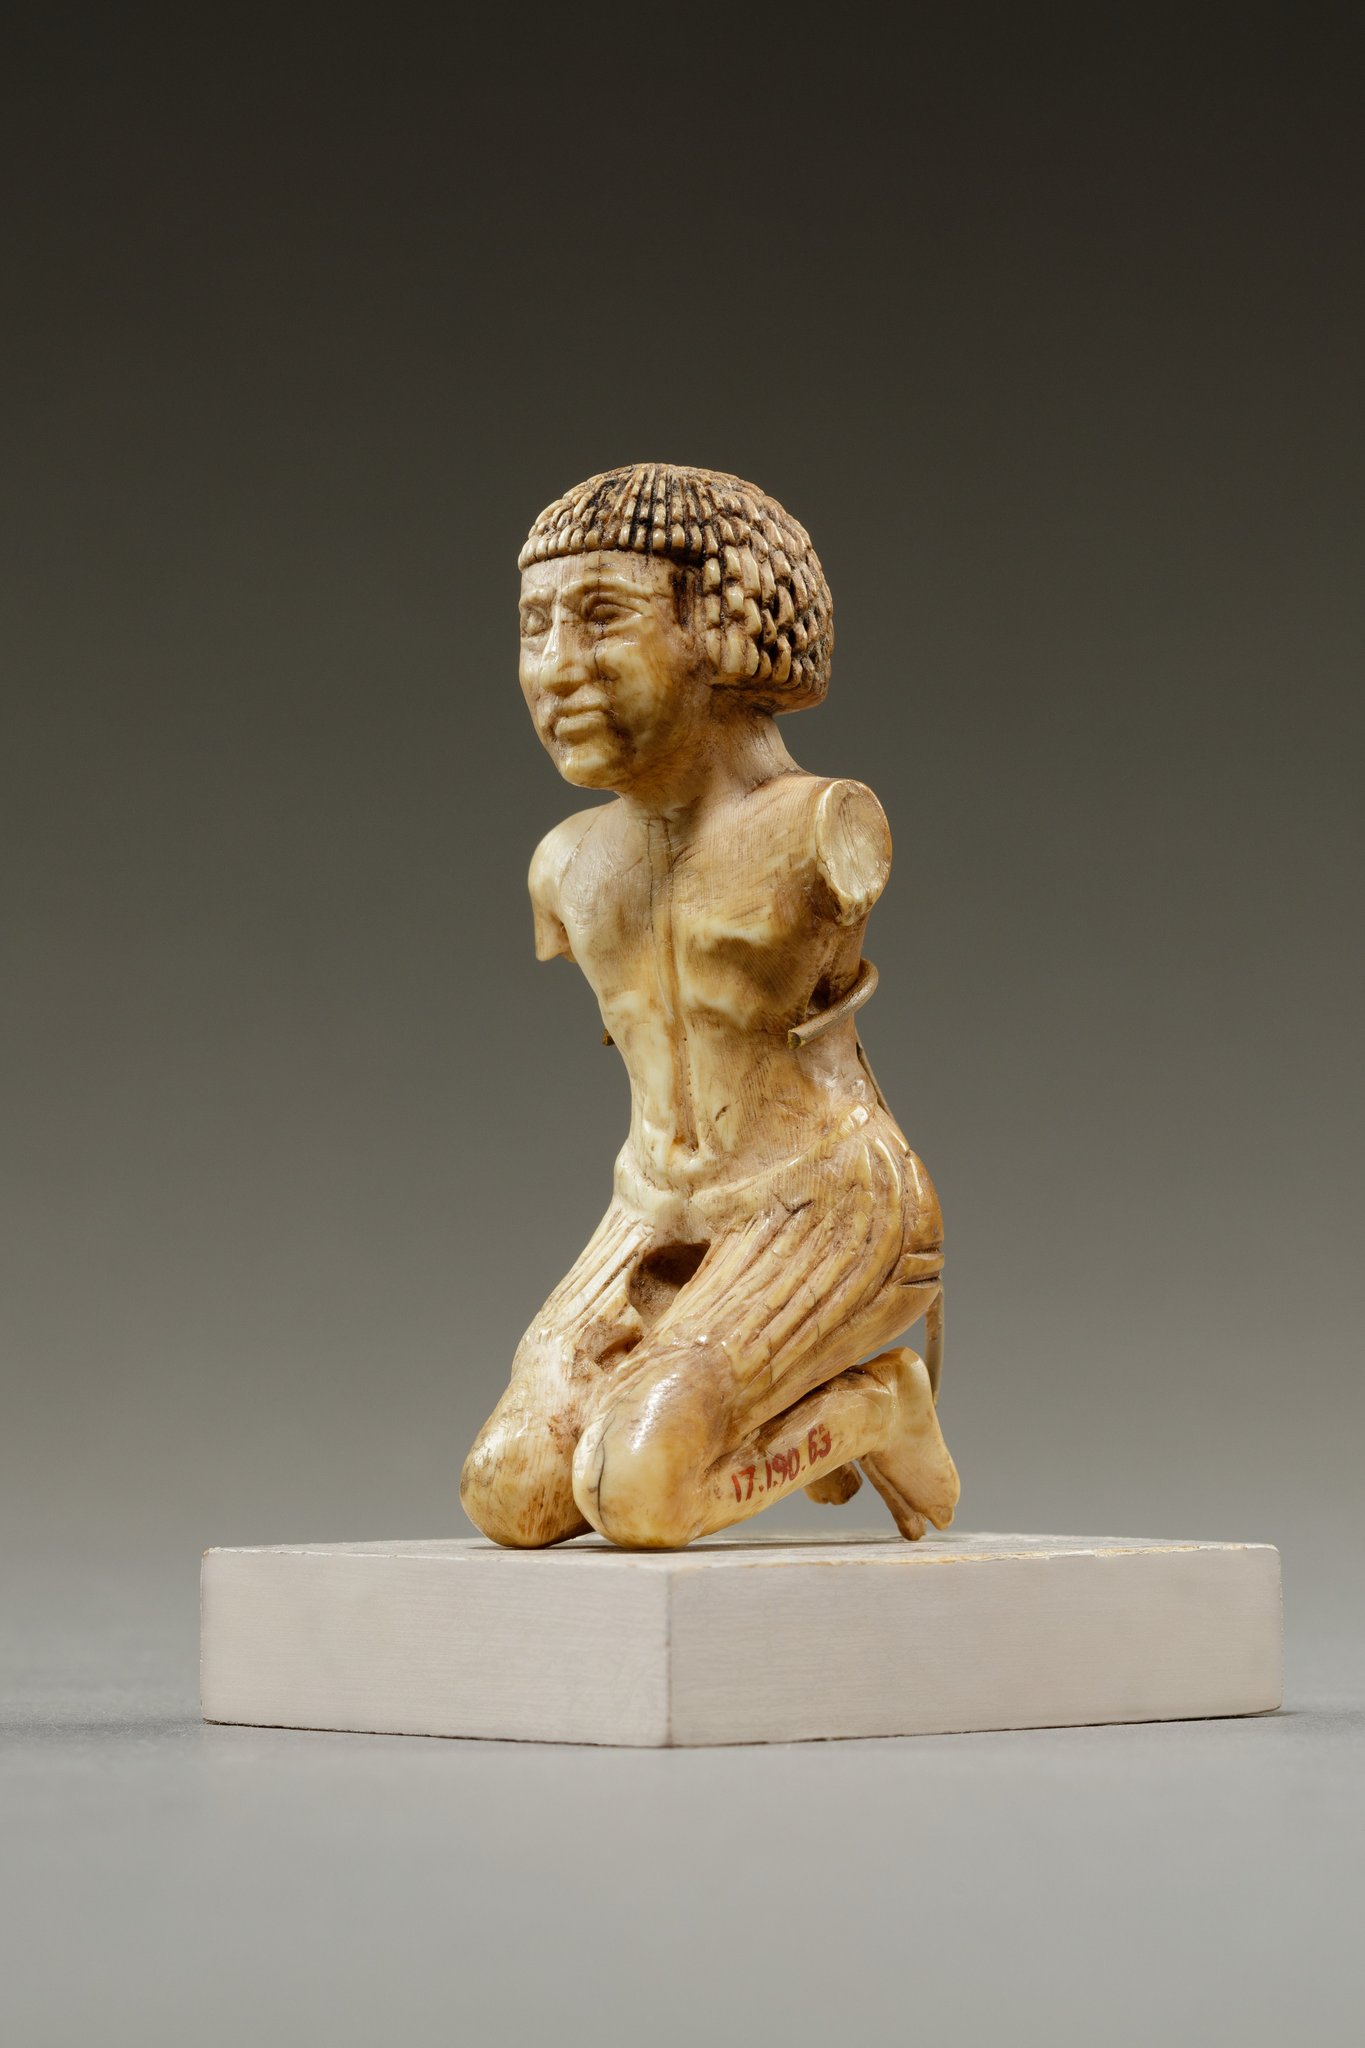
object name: statuette, bound asiatic captive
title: Bound Asiatic Captive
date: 664-525 BCE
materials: ivory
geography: egypt